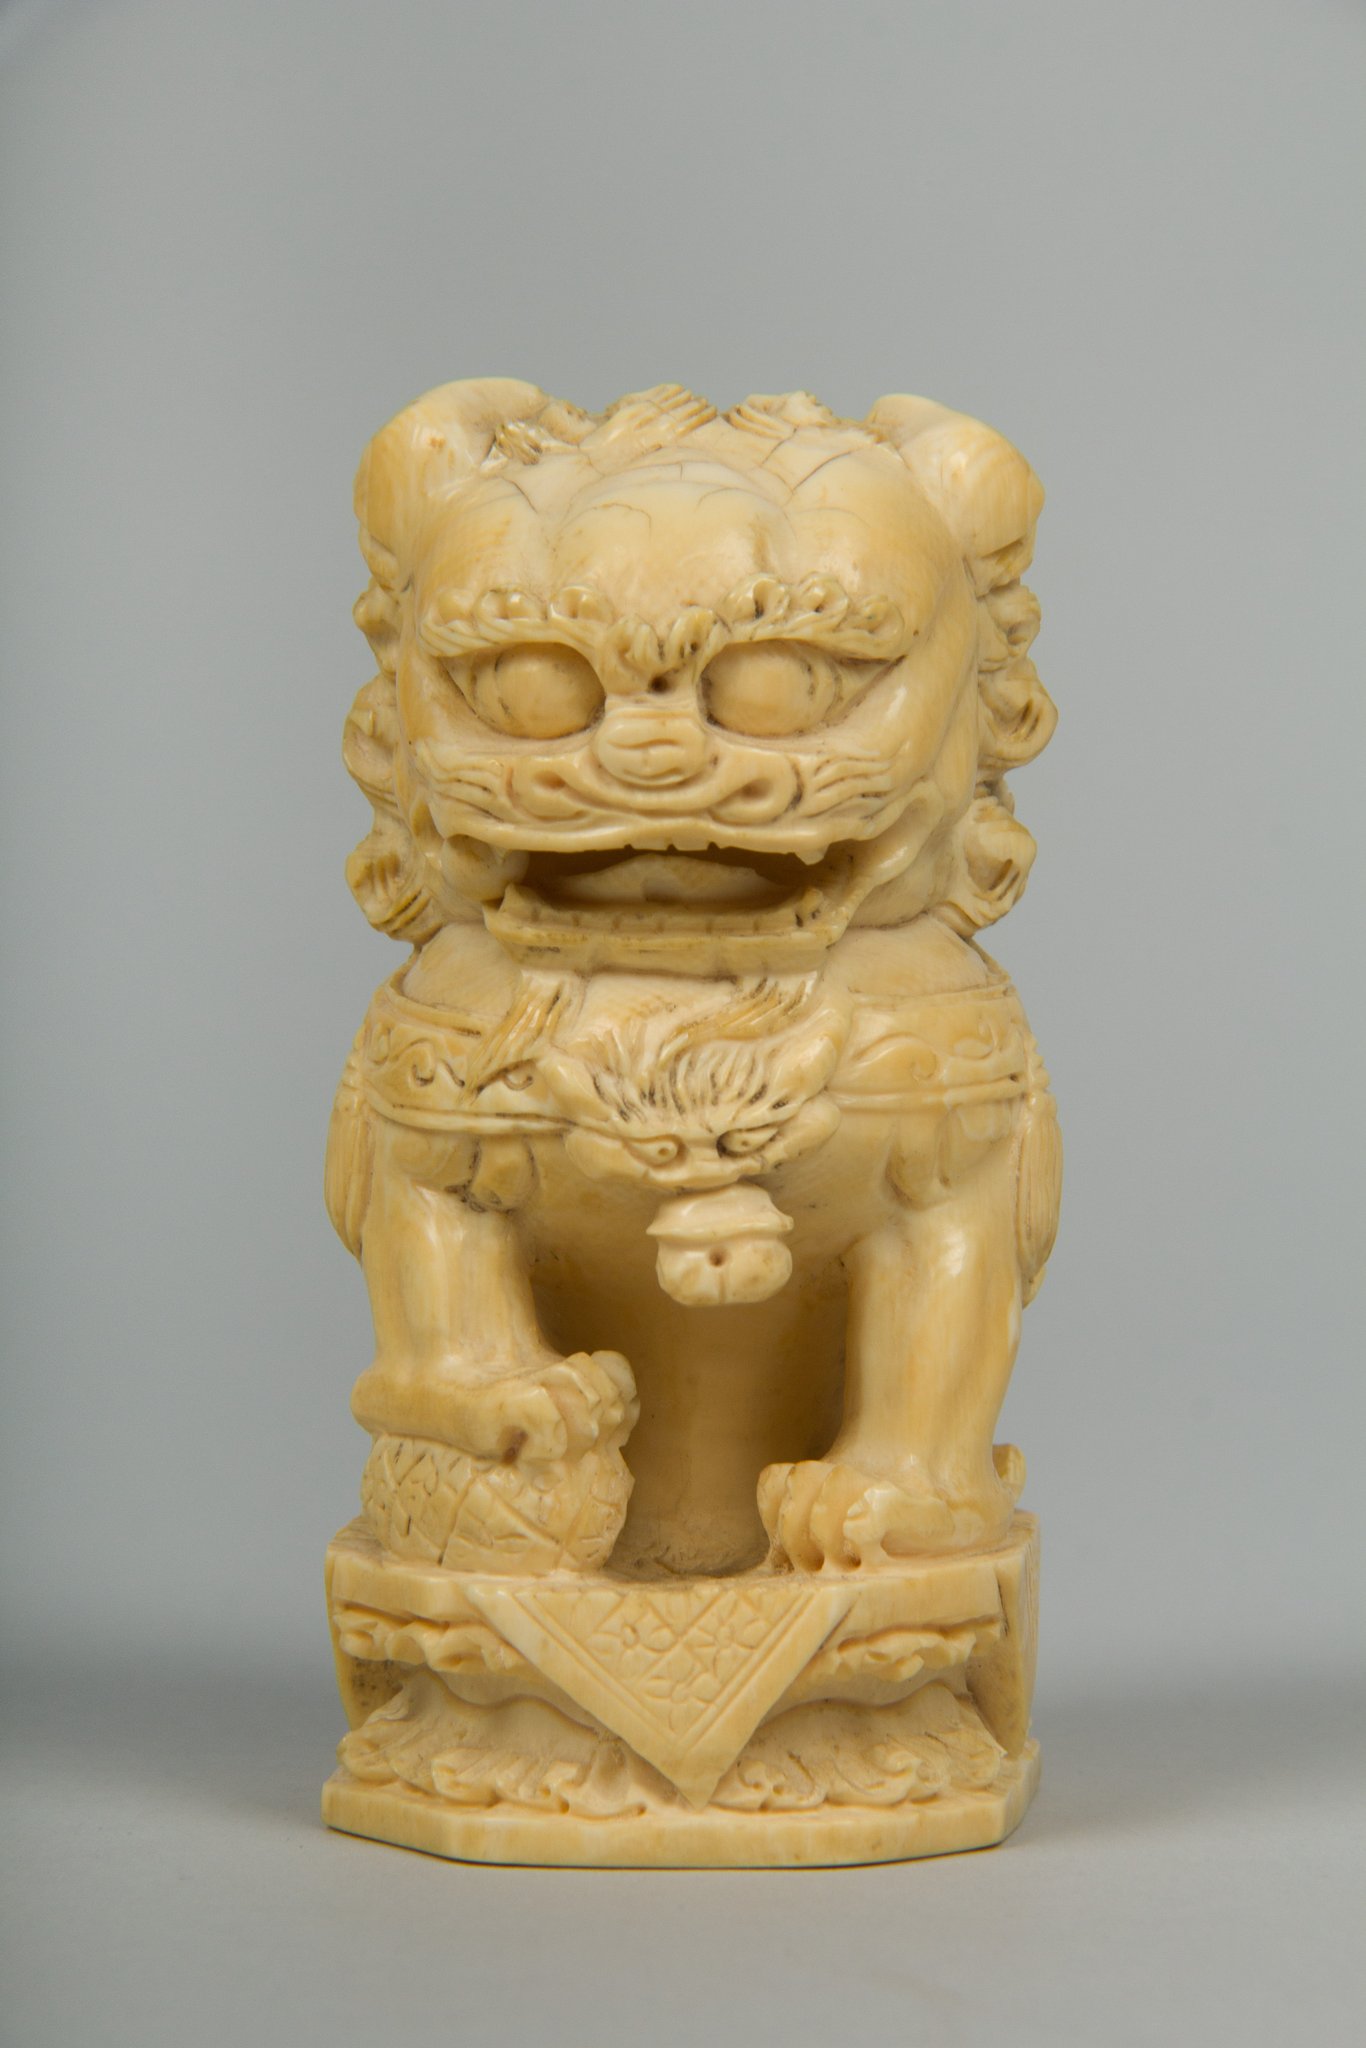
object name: figure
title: Seal with a Seated Lion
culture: chinese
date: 1801-2000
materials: ivory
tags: lions